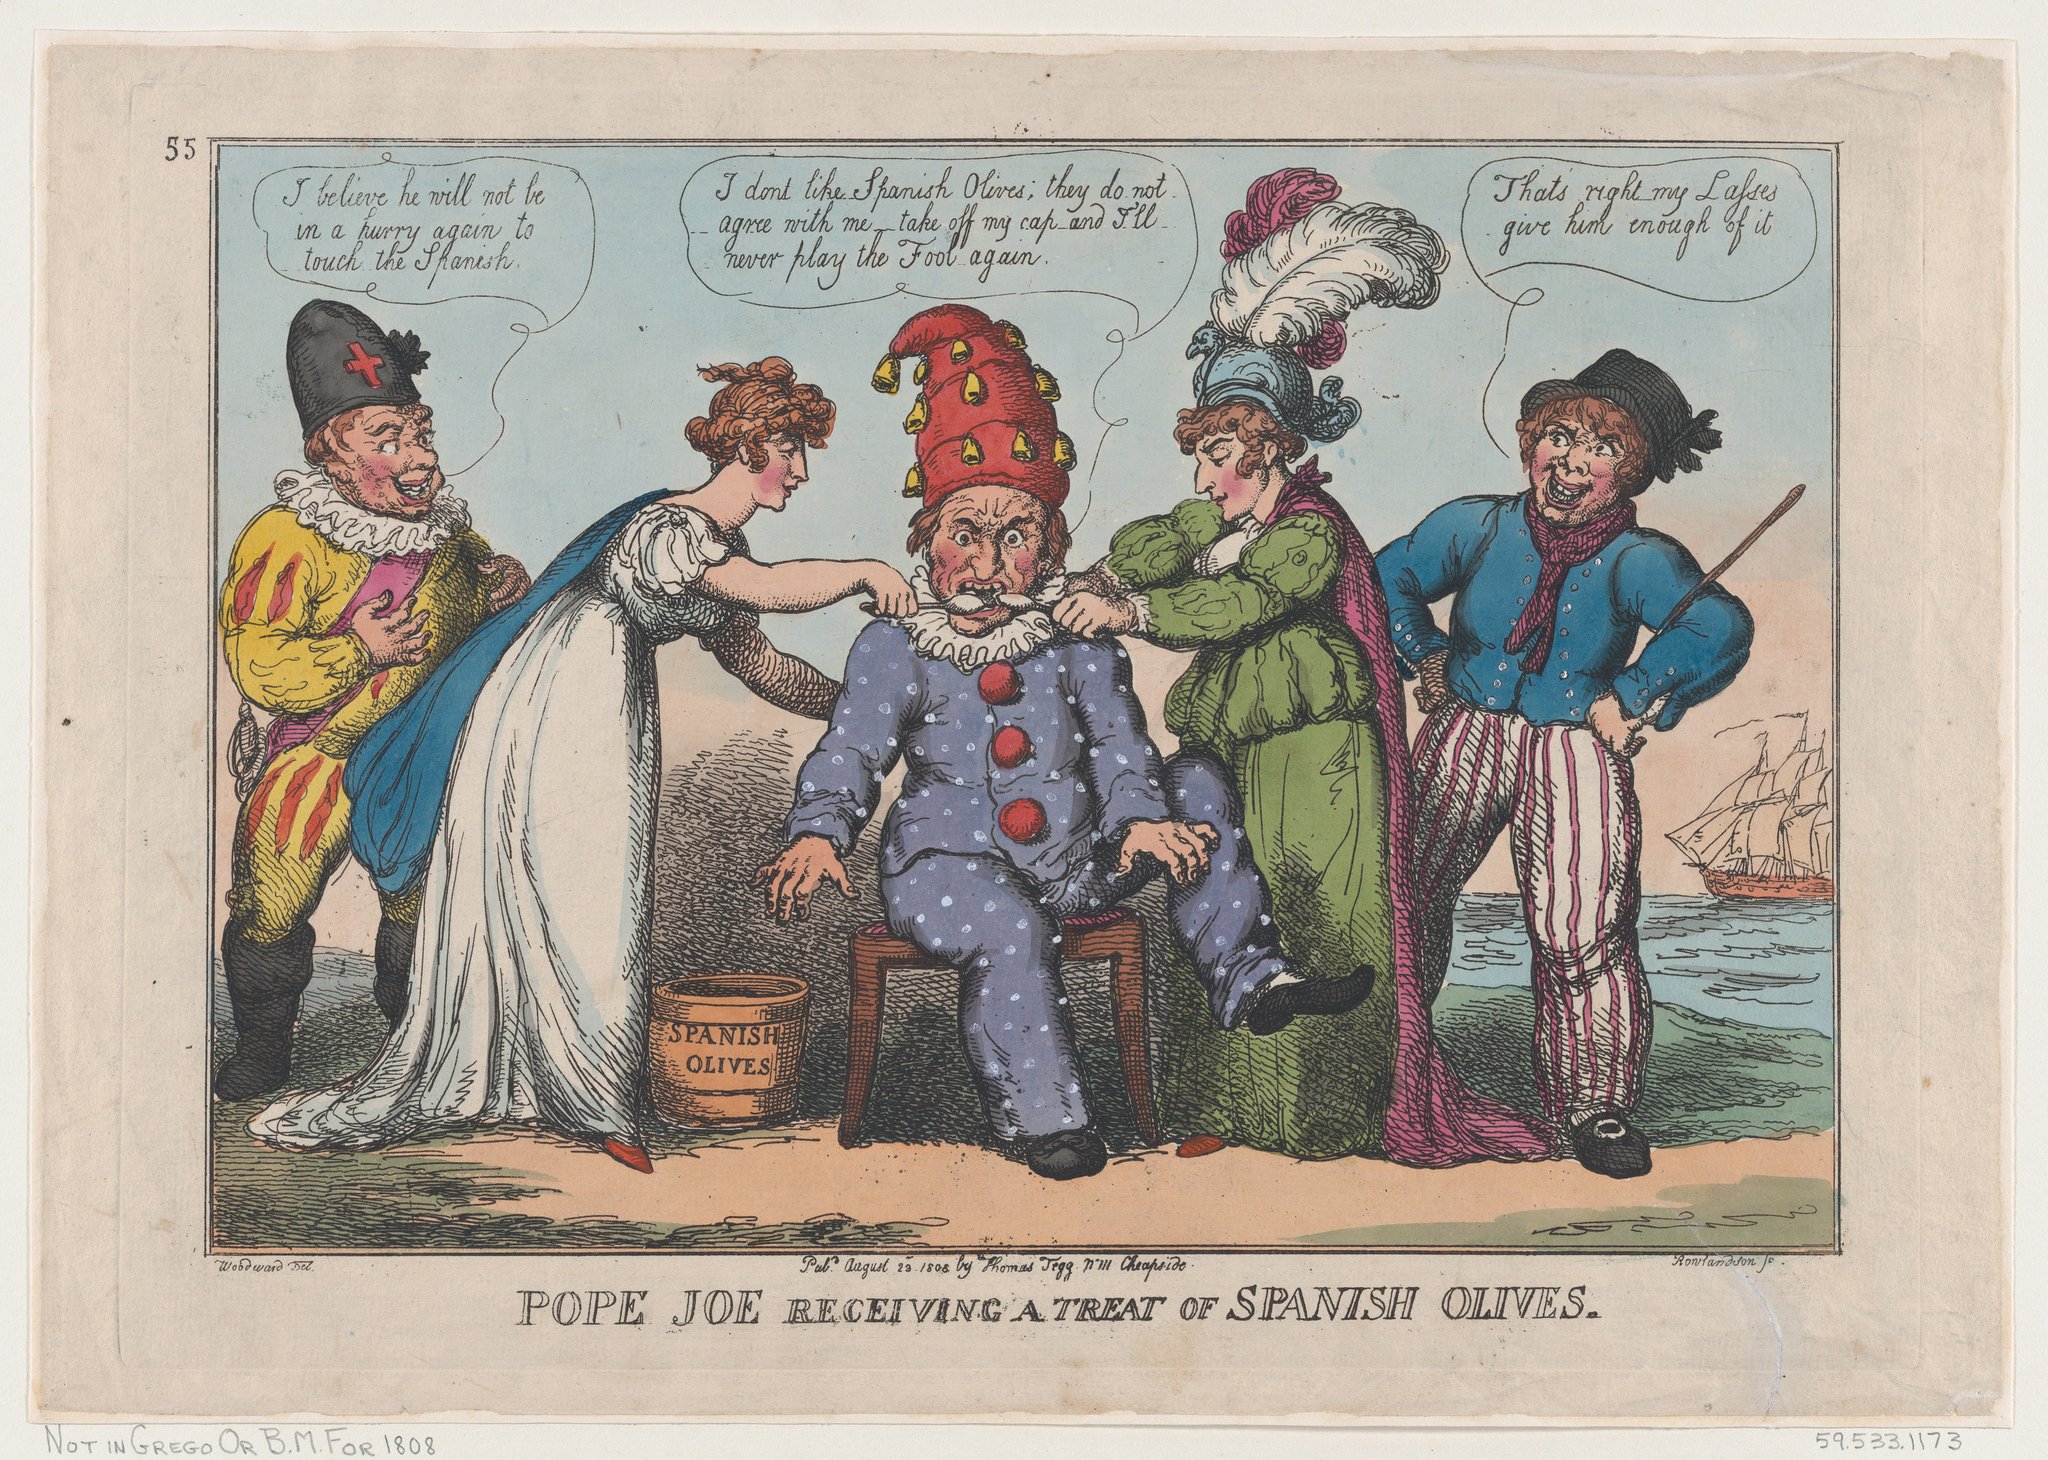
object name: print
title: Pope Joe Receiving a Treat of Spanish Olives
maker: thomas rowlandson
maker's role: artist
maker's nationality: british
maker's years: 1757-1827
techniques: etching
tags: satire,men,women,politics